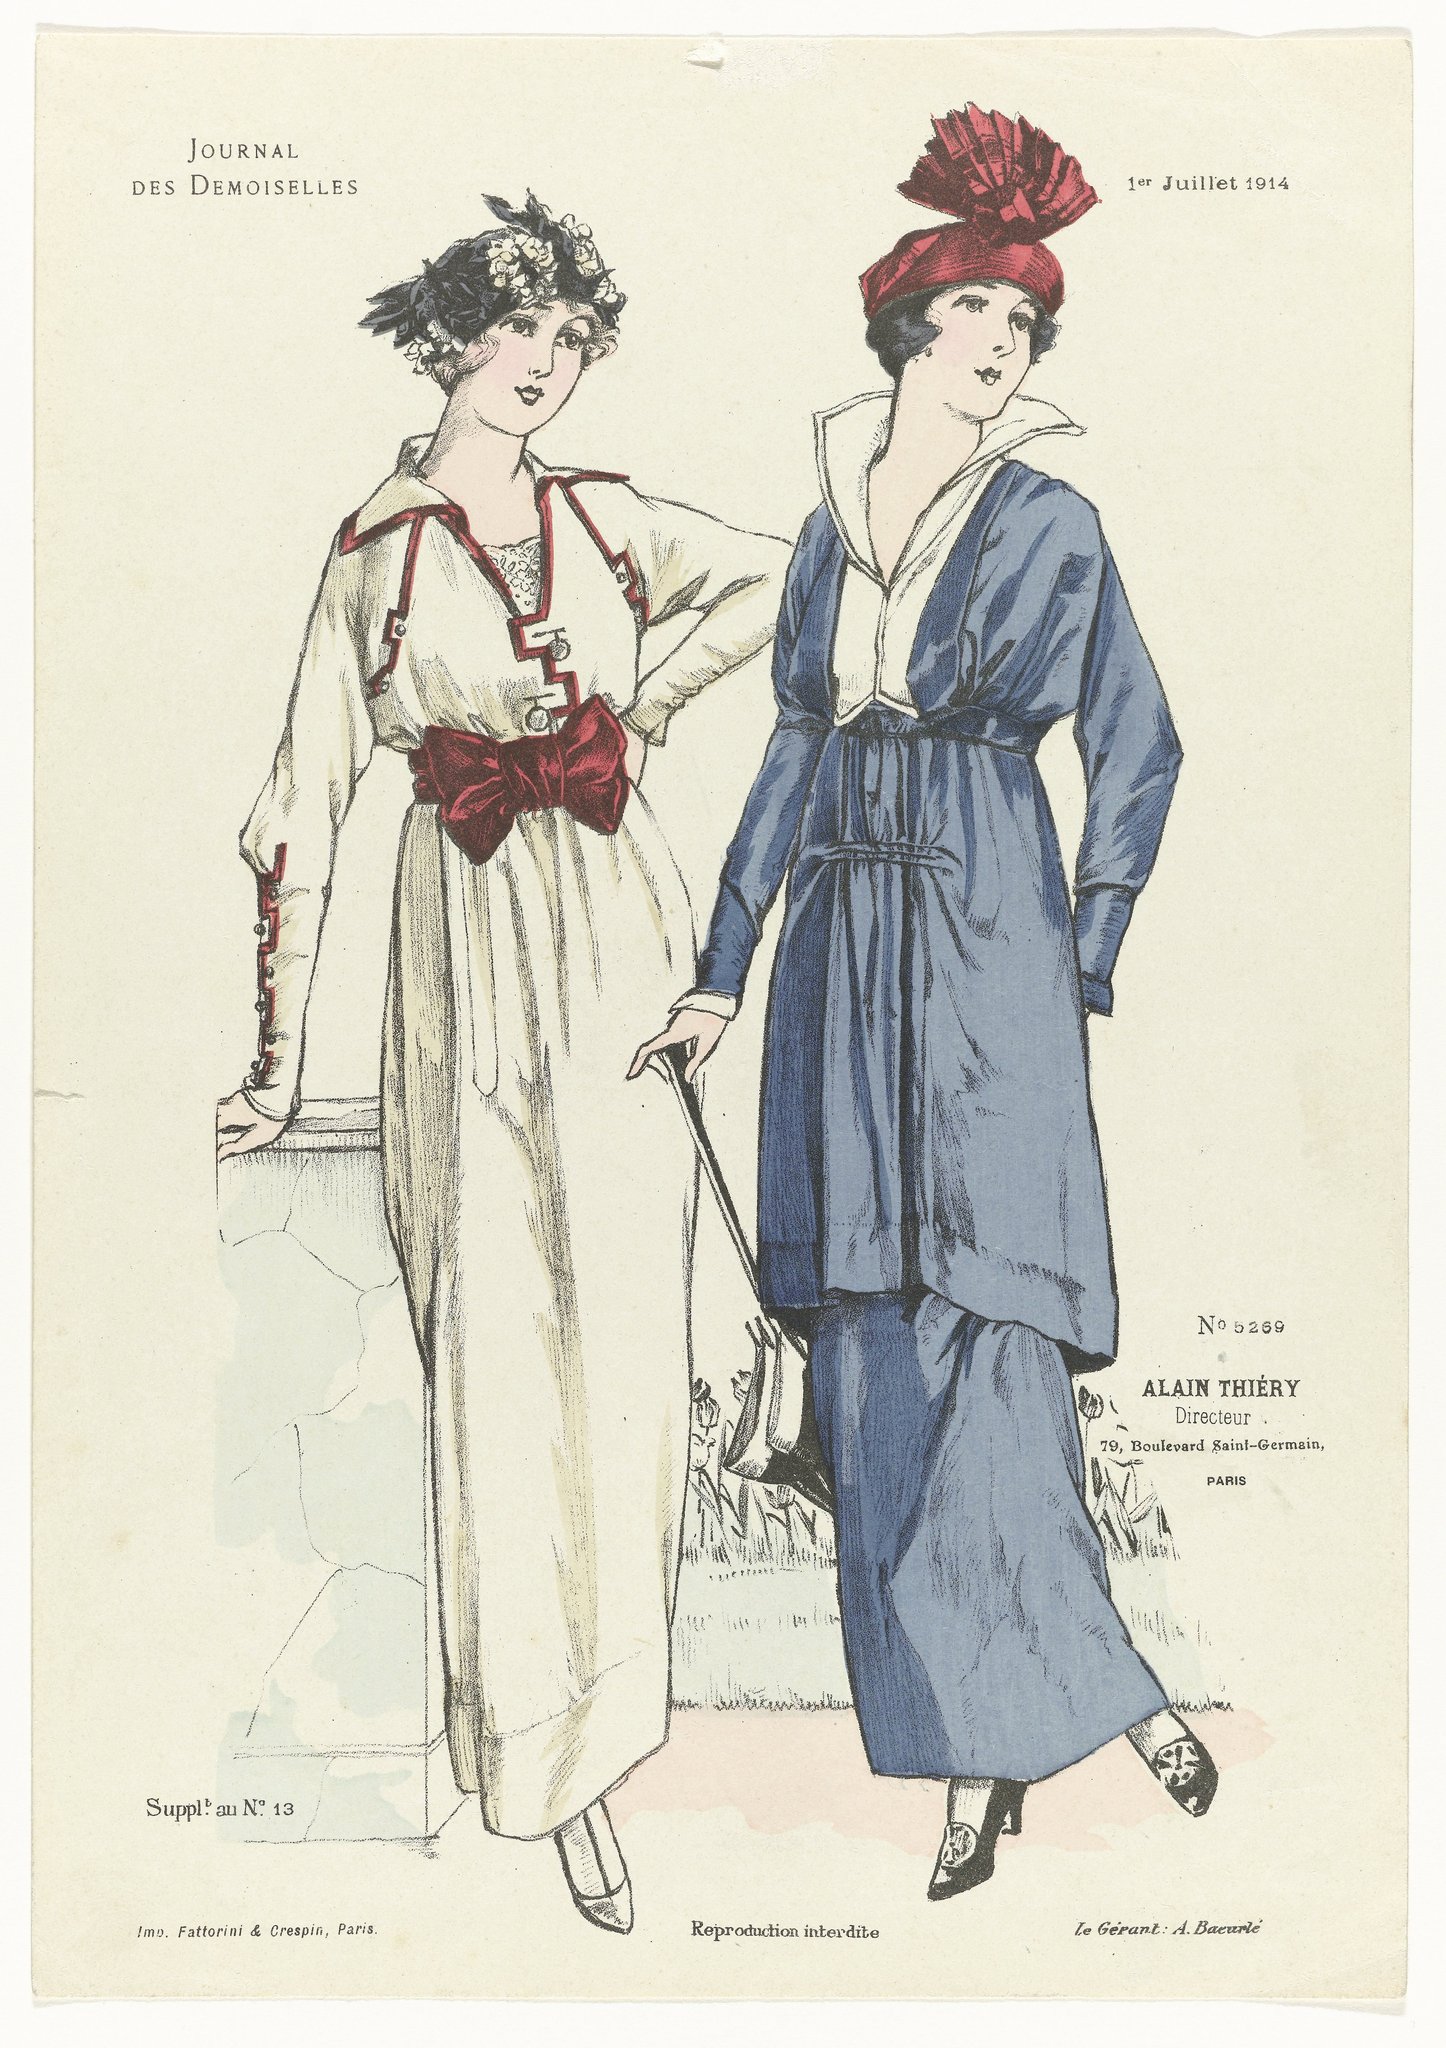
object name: fashion print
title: Journal des Demoiselles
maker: Anonymous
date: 1914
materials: paper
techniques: hand coloring, lithograph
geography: paris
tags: head-gear (+ women's clothes), fashion plates, skirt (+ women's clothes), dress, gown (+ women's clothes)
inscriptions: address: ‘No 5269 / Alain Thiéry Directeur / 79, Boulevard Saint Germain, Paris’, title: ‘Journal des Demoiselles / 1er juillet 1914’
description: The Journal des Demoiselles had been published since 1833 as a fashion magazine for young women. In the 1914-1915 season it presented an ankle-length skirt so narrow it was nicknamed the ‘hobble skirt’. The slim silhouette was completed with either a small cap known as a toque or a broad-brimmed hat. Parasols continued to be an indispensable accessory to shield one’s face from the sun and, more importantly, to prevent it from becoming tanned.